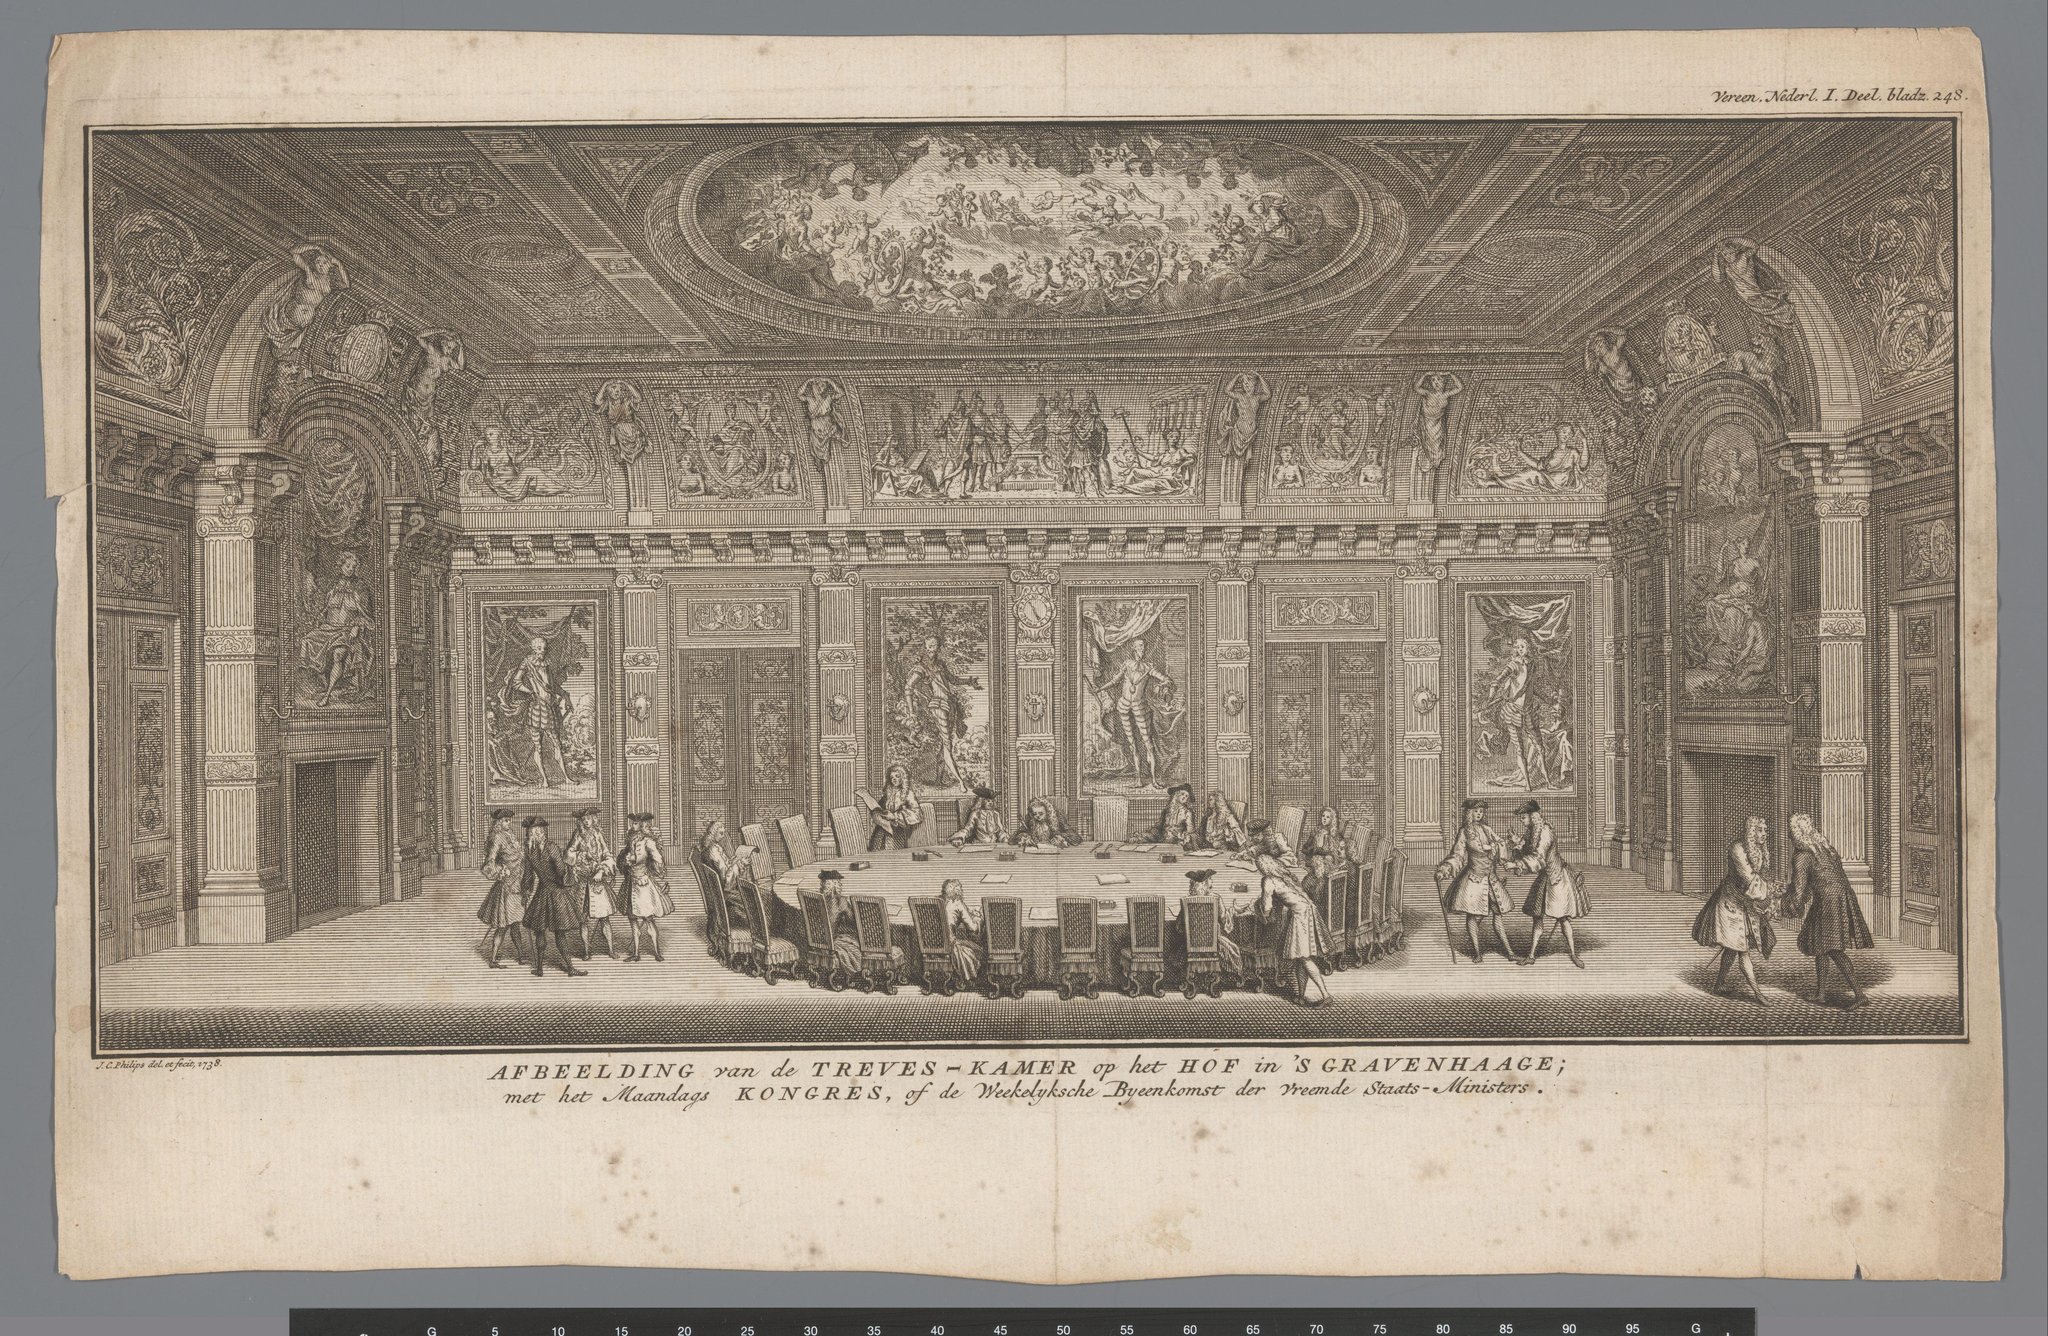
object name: print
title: Afbeelding van de Treves-Kamer op het Hof in 's Gravenhaage; met het Maandags Kongres, of de Weekelyksche Byeenkomst der Vreemde Staats-Ministers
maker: jan caspar philips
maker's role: draughtsman, print maker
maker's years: 1700-1775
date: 1738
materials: paper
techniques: engraving, etching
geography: amsterdam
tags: national government, lower house, parliament, chamber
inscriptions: date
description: Prent gebruikt in: Tegenwoordige staat der Vereenigde Nederlanden, dl I. Amsterdam: Isaak Tirion, 1739.